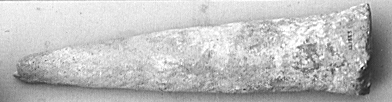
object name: cone, uninscribed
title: Funerary cone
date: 2124-1981 BCE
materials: paint, pottery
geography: egypt